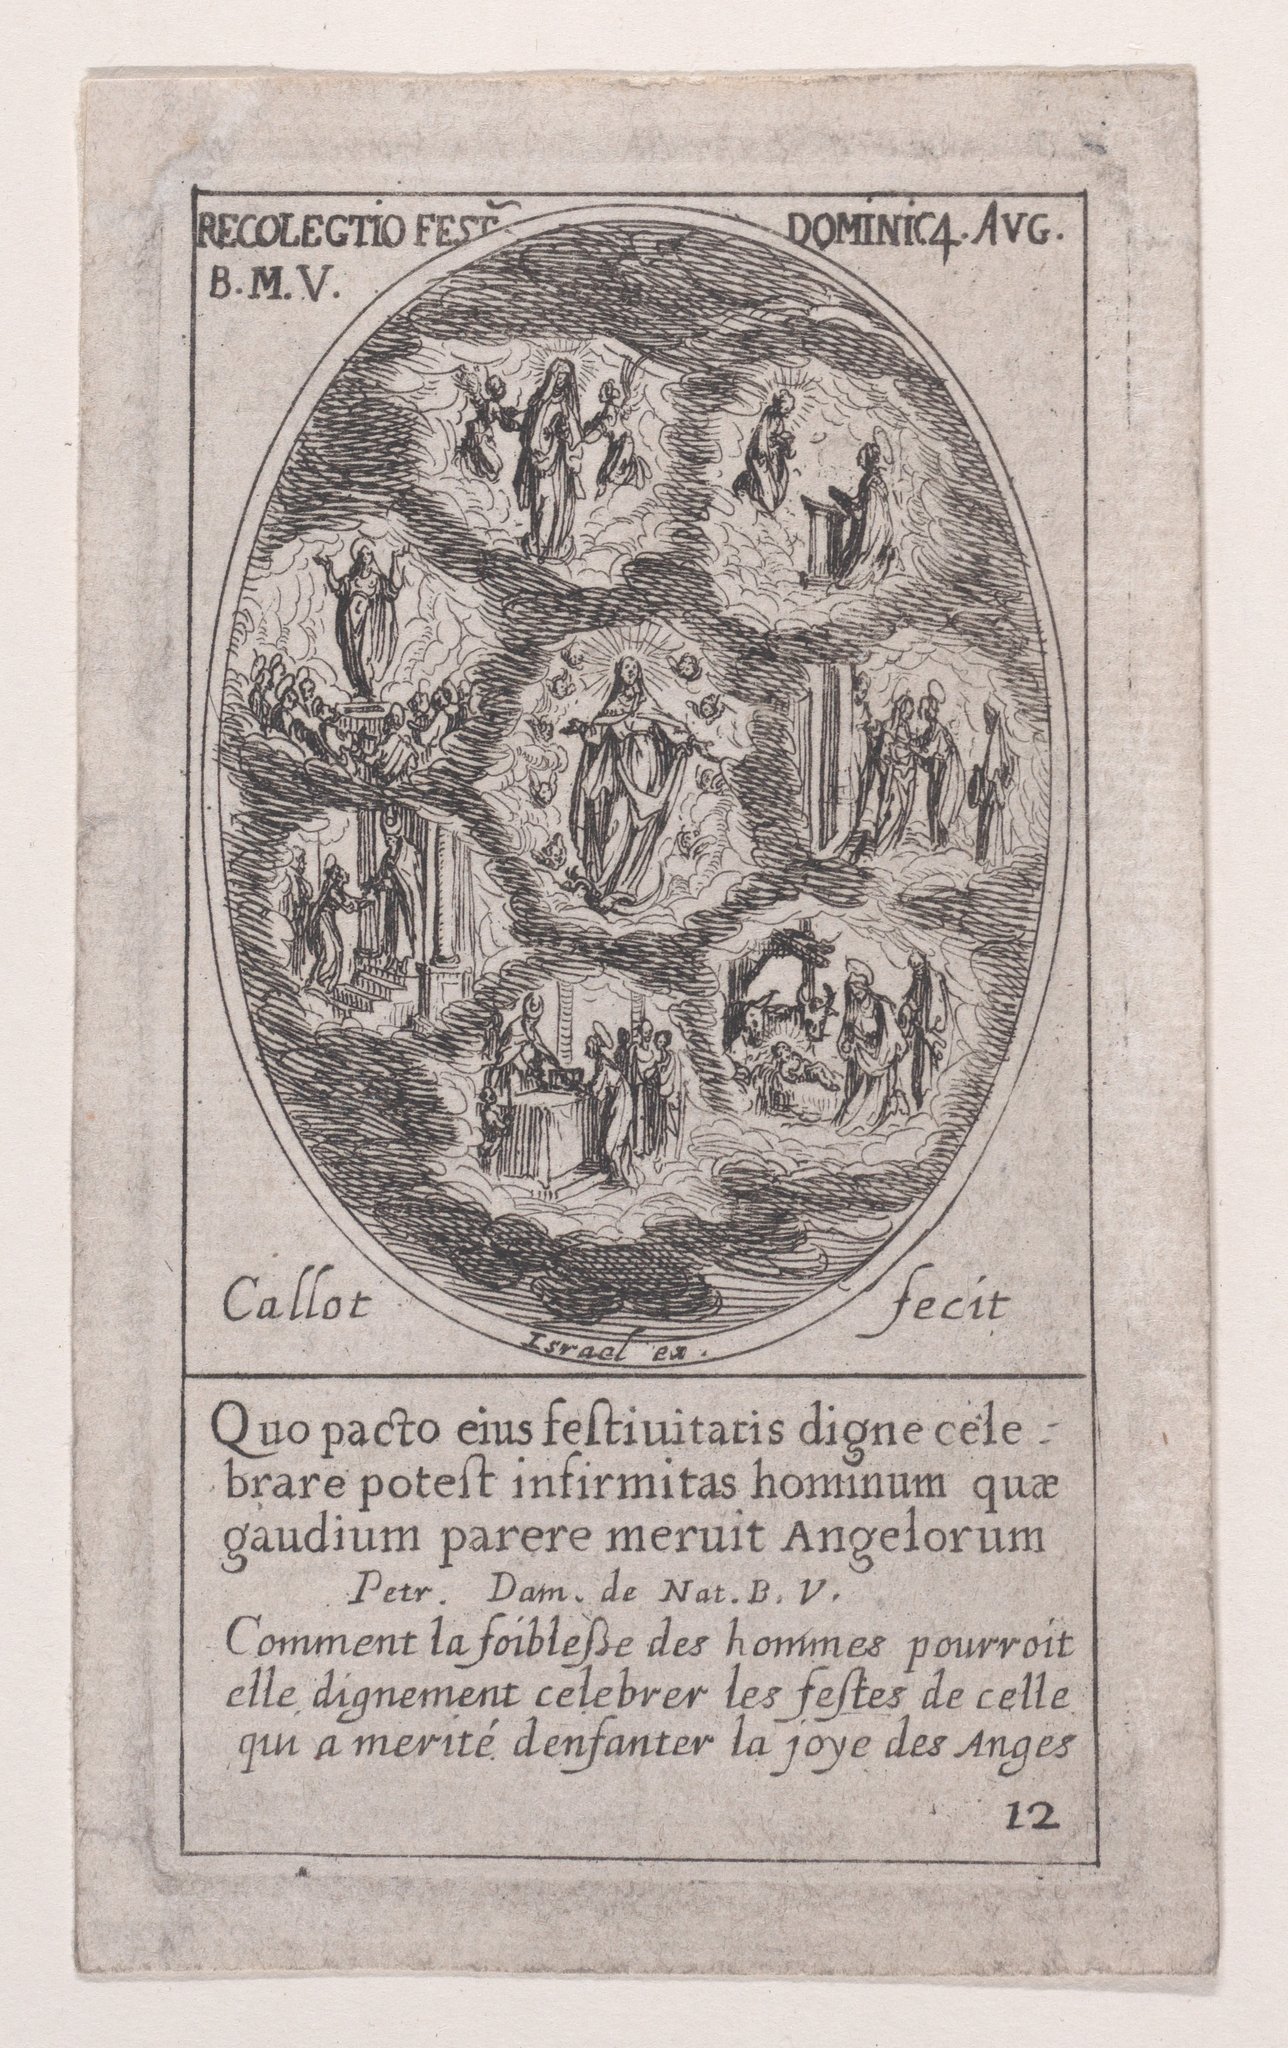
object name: print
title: Réunion des fêtes de la Sainte Vierge (Collection of the Feasts Dedicated to the Virgin): The Immaculate Conception, The Visitation, The Birth of Christ, The Presentation at the Temple, The Purification, The Assumption, and the Reception of the Virgin in Heaven, scene 12 from Images des Fêtes Mobiles (Images of Moveable Feasts from the Christian Calendar), part of the series "Les Images De Tous Les Saincts et Saintes de L'Année" (Images of All of the Saints and Religious Events of the Year)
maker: jacques callot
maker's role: artist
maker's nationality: french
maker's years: 1592-1635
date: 1632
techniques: etching